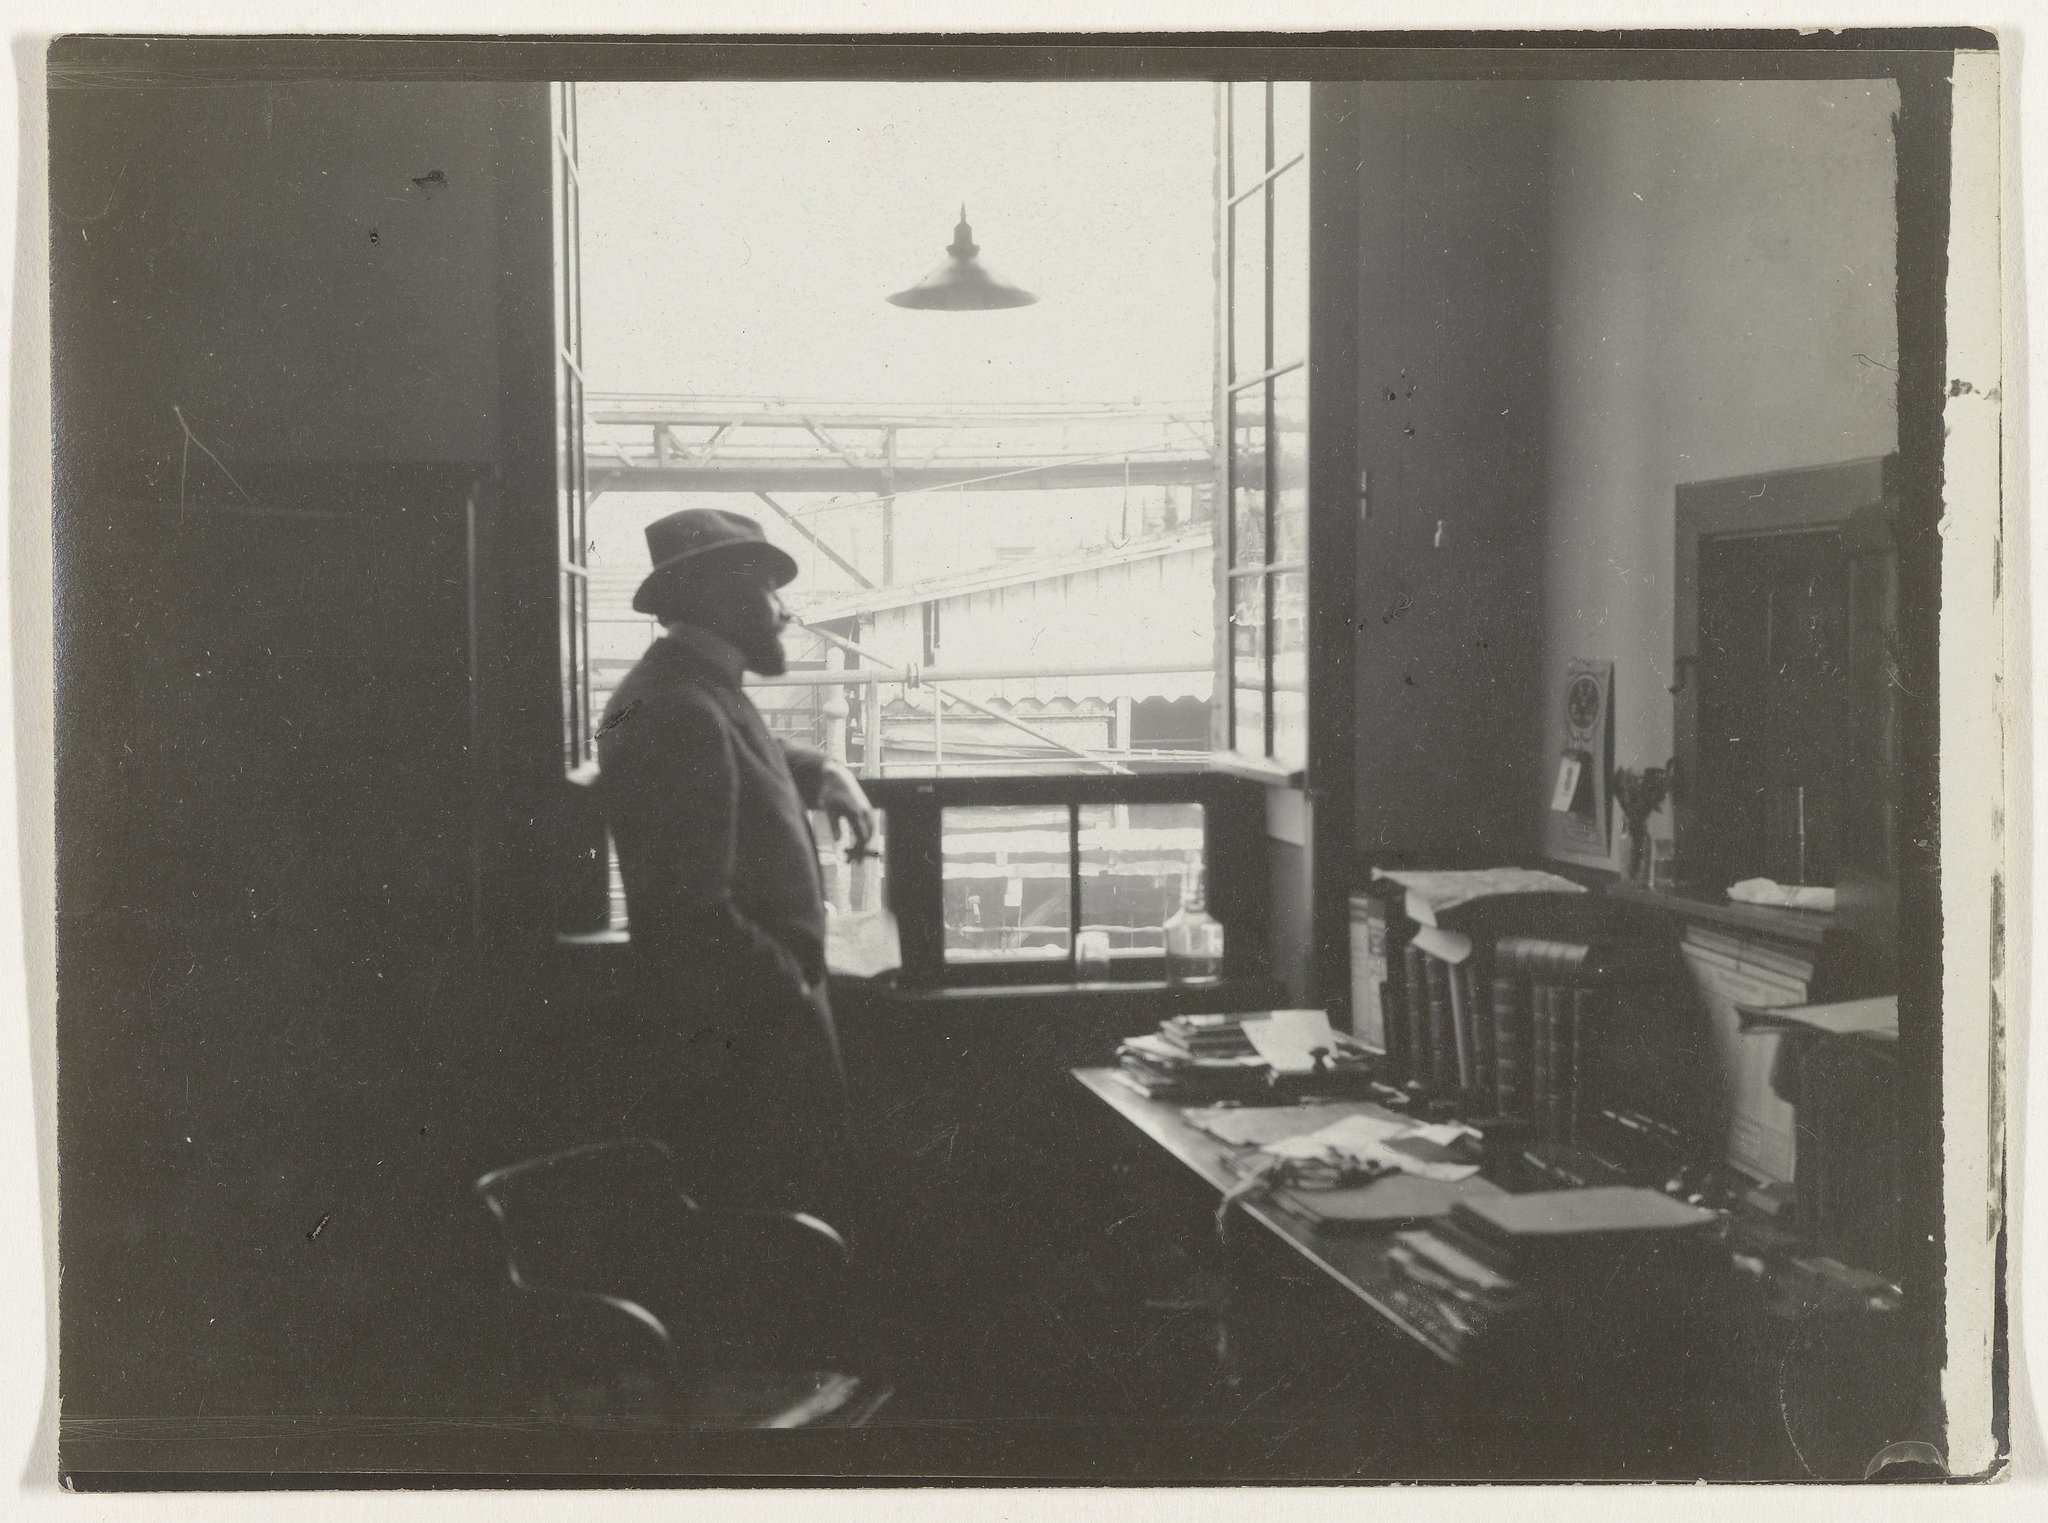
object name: photograph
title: Man die uit het raam kijkt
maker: Anonymous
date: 1900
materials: paper, photographic support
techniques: gelatin silver print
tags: human figure at (open) window, seen from inside